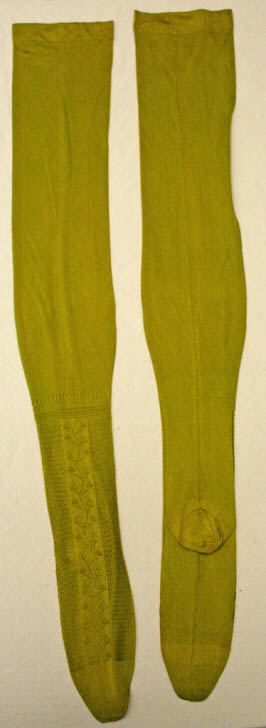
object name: stocking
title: Stockings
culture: french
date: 1801-1900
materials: silk